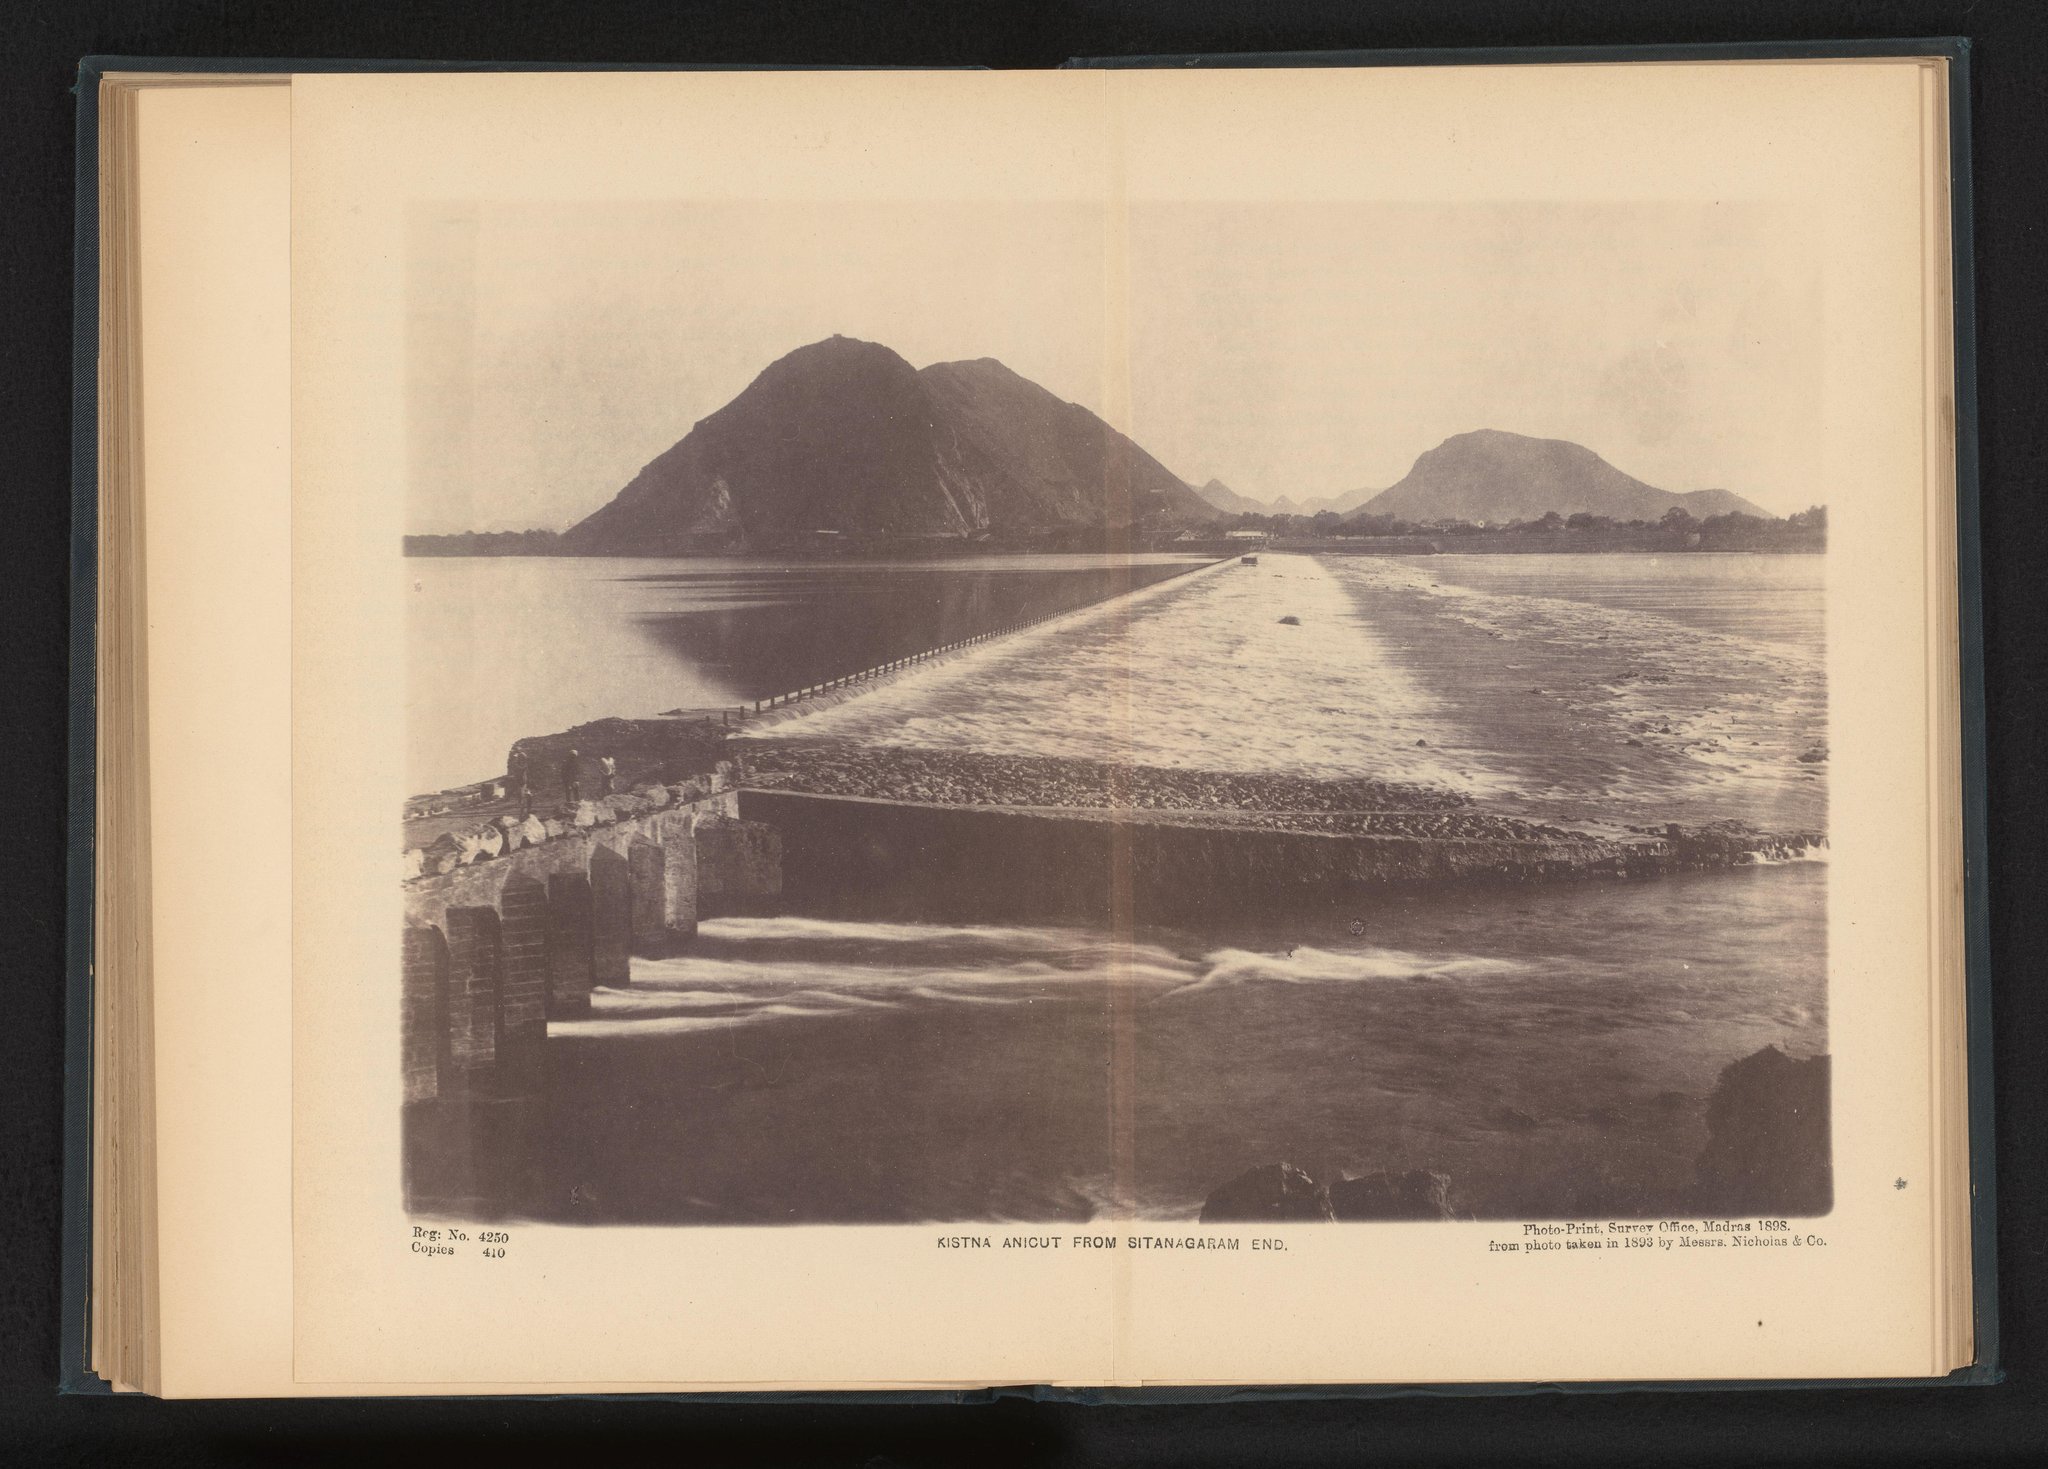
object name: photomechanical print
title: Kistna Anicut from Sitanagaram end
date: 1898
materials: paper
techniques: photograph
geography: sitanagaram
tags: river, dam (in canal)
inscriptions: number: ‘Reg. No. 4250 Copies 410’